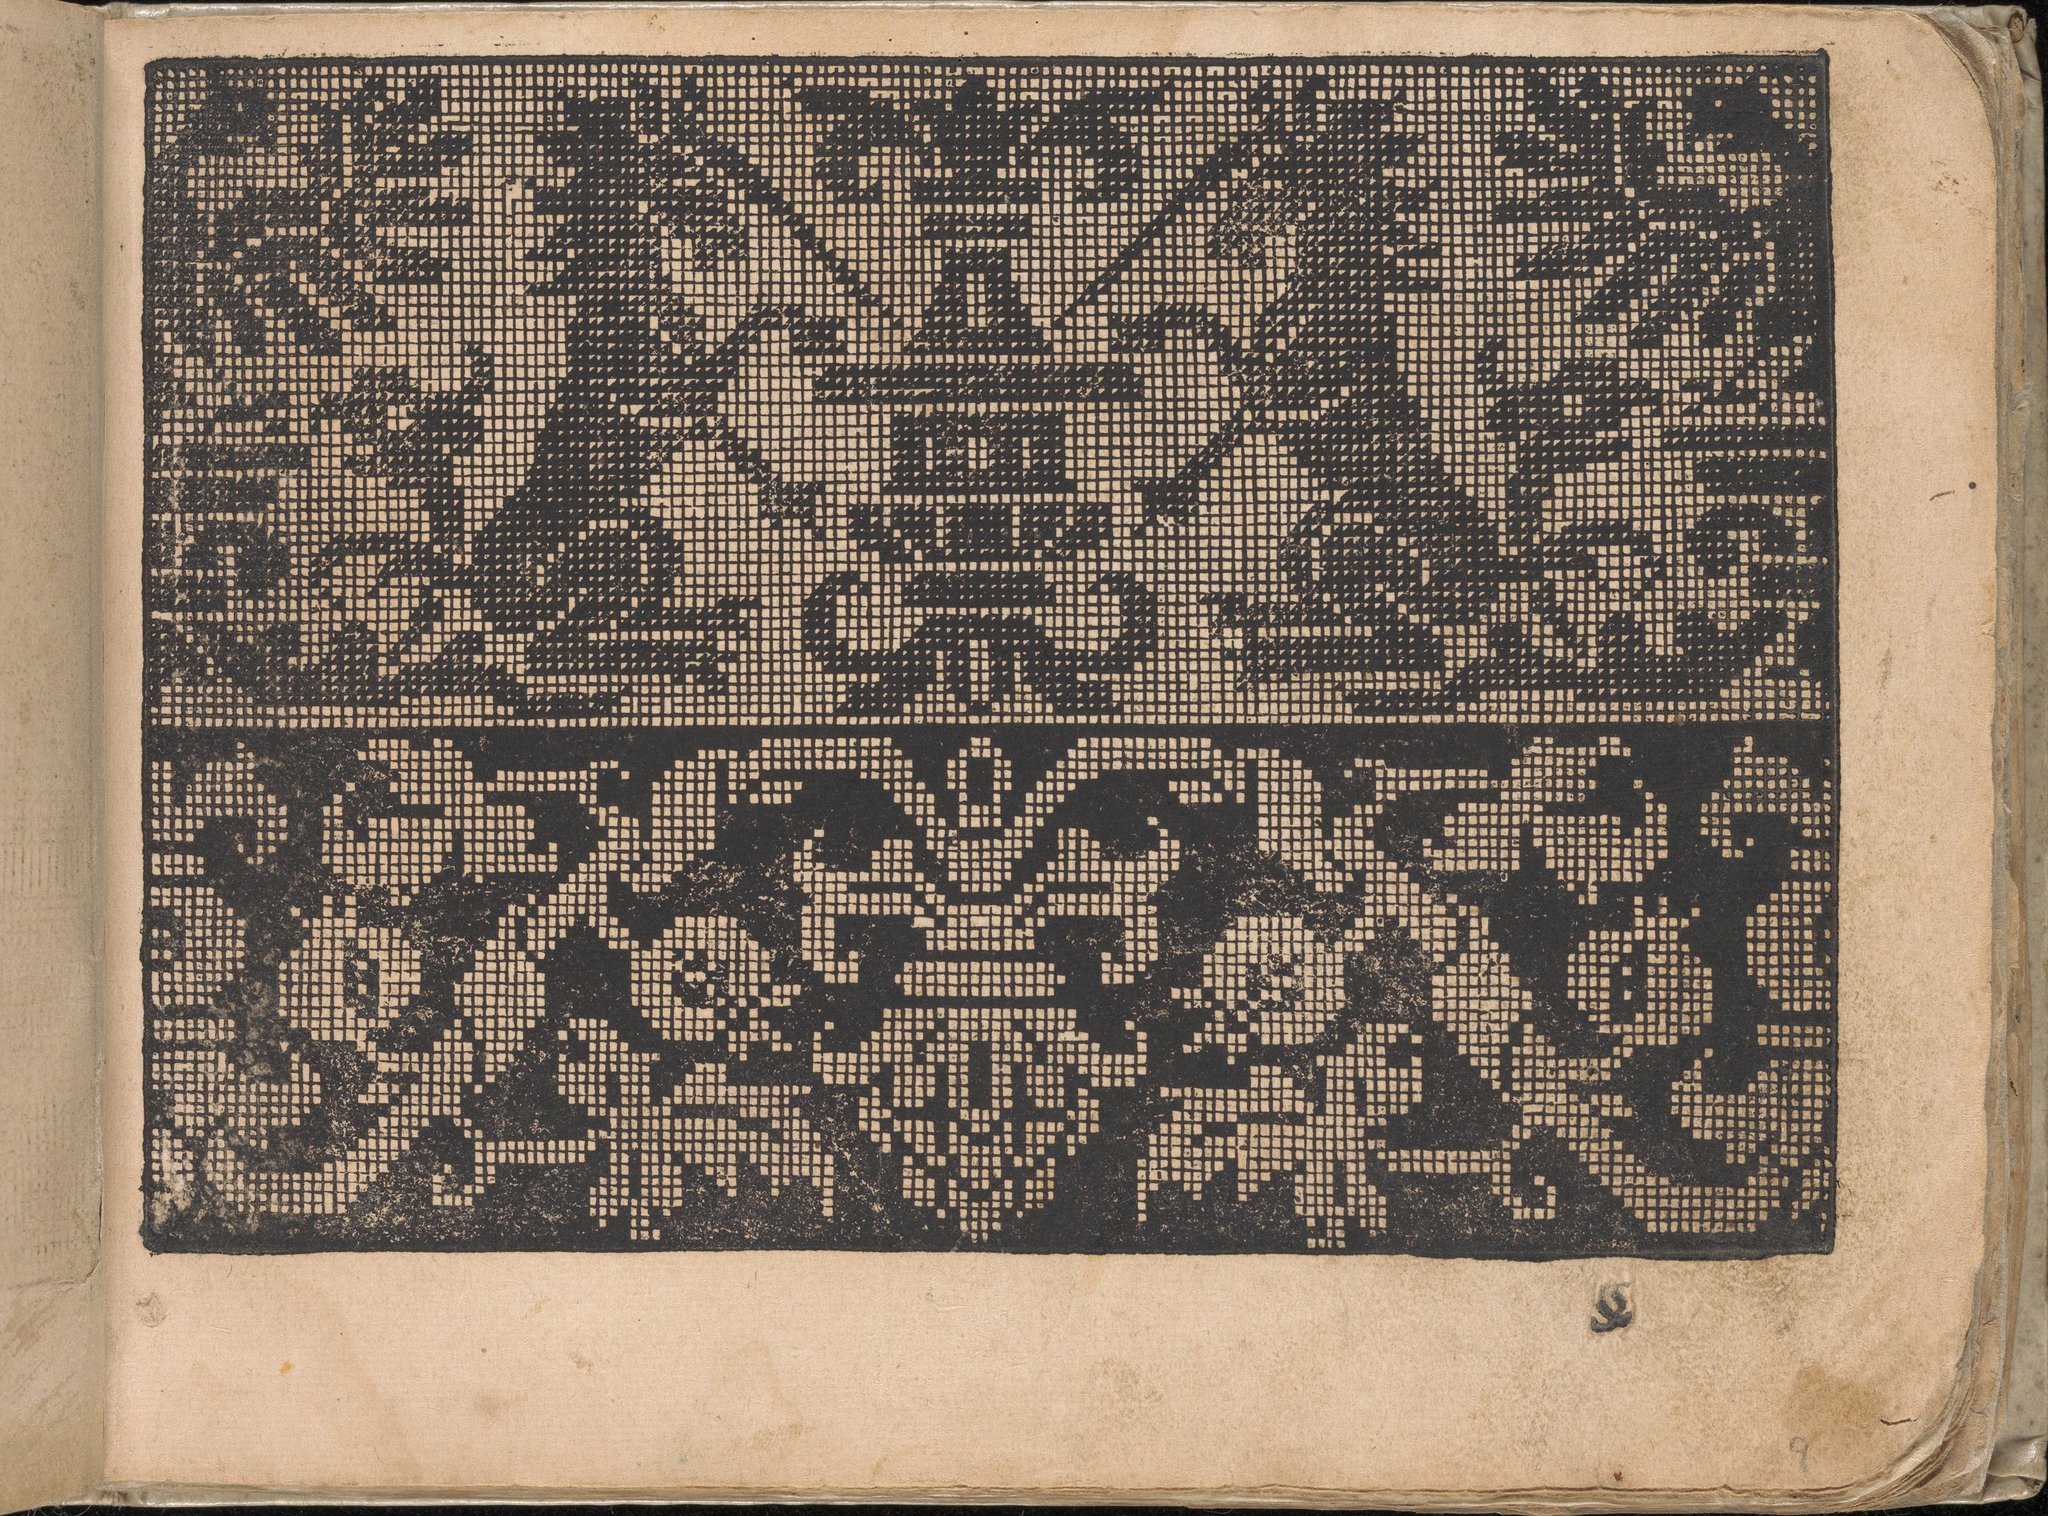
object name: book print ornament architecture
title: Neu künstlich Modelbuch (page 9r)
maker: bernhard jobin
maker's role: publisher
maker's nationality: swiss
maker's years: 1535-1597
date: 1598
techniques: woodcut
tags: coat of arms